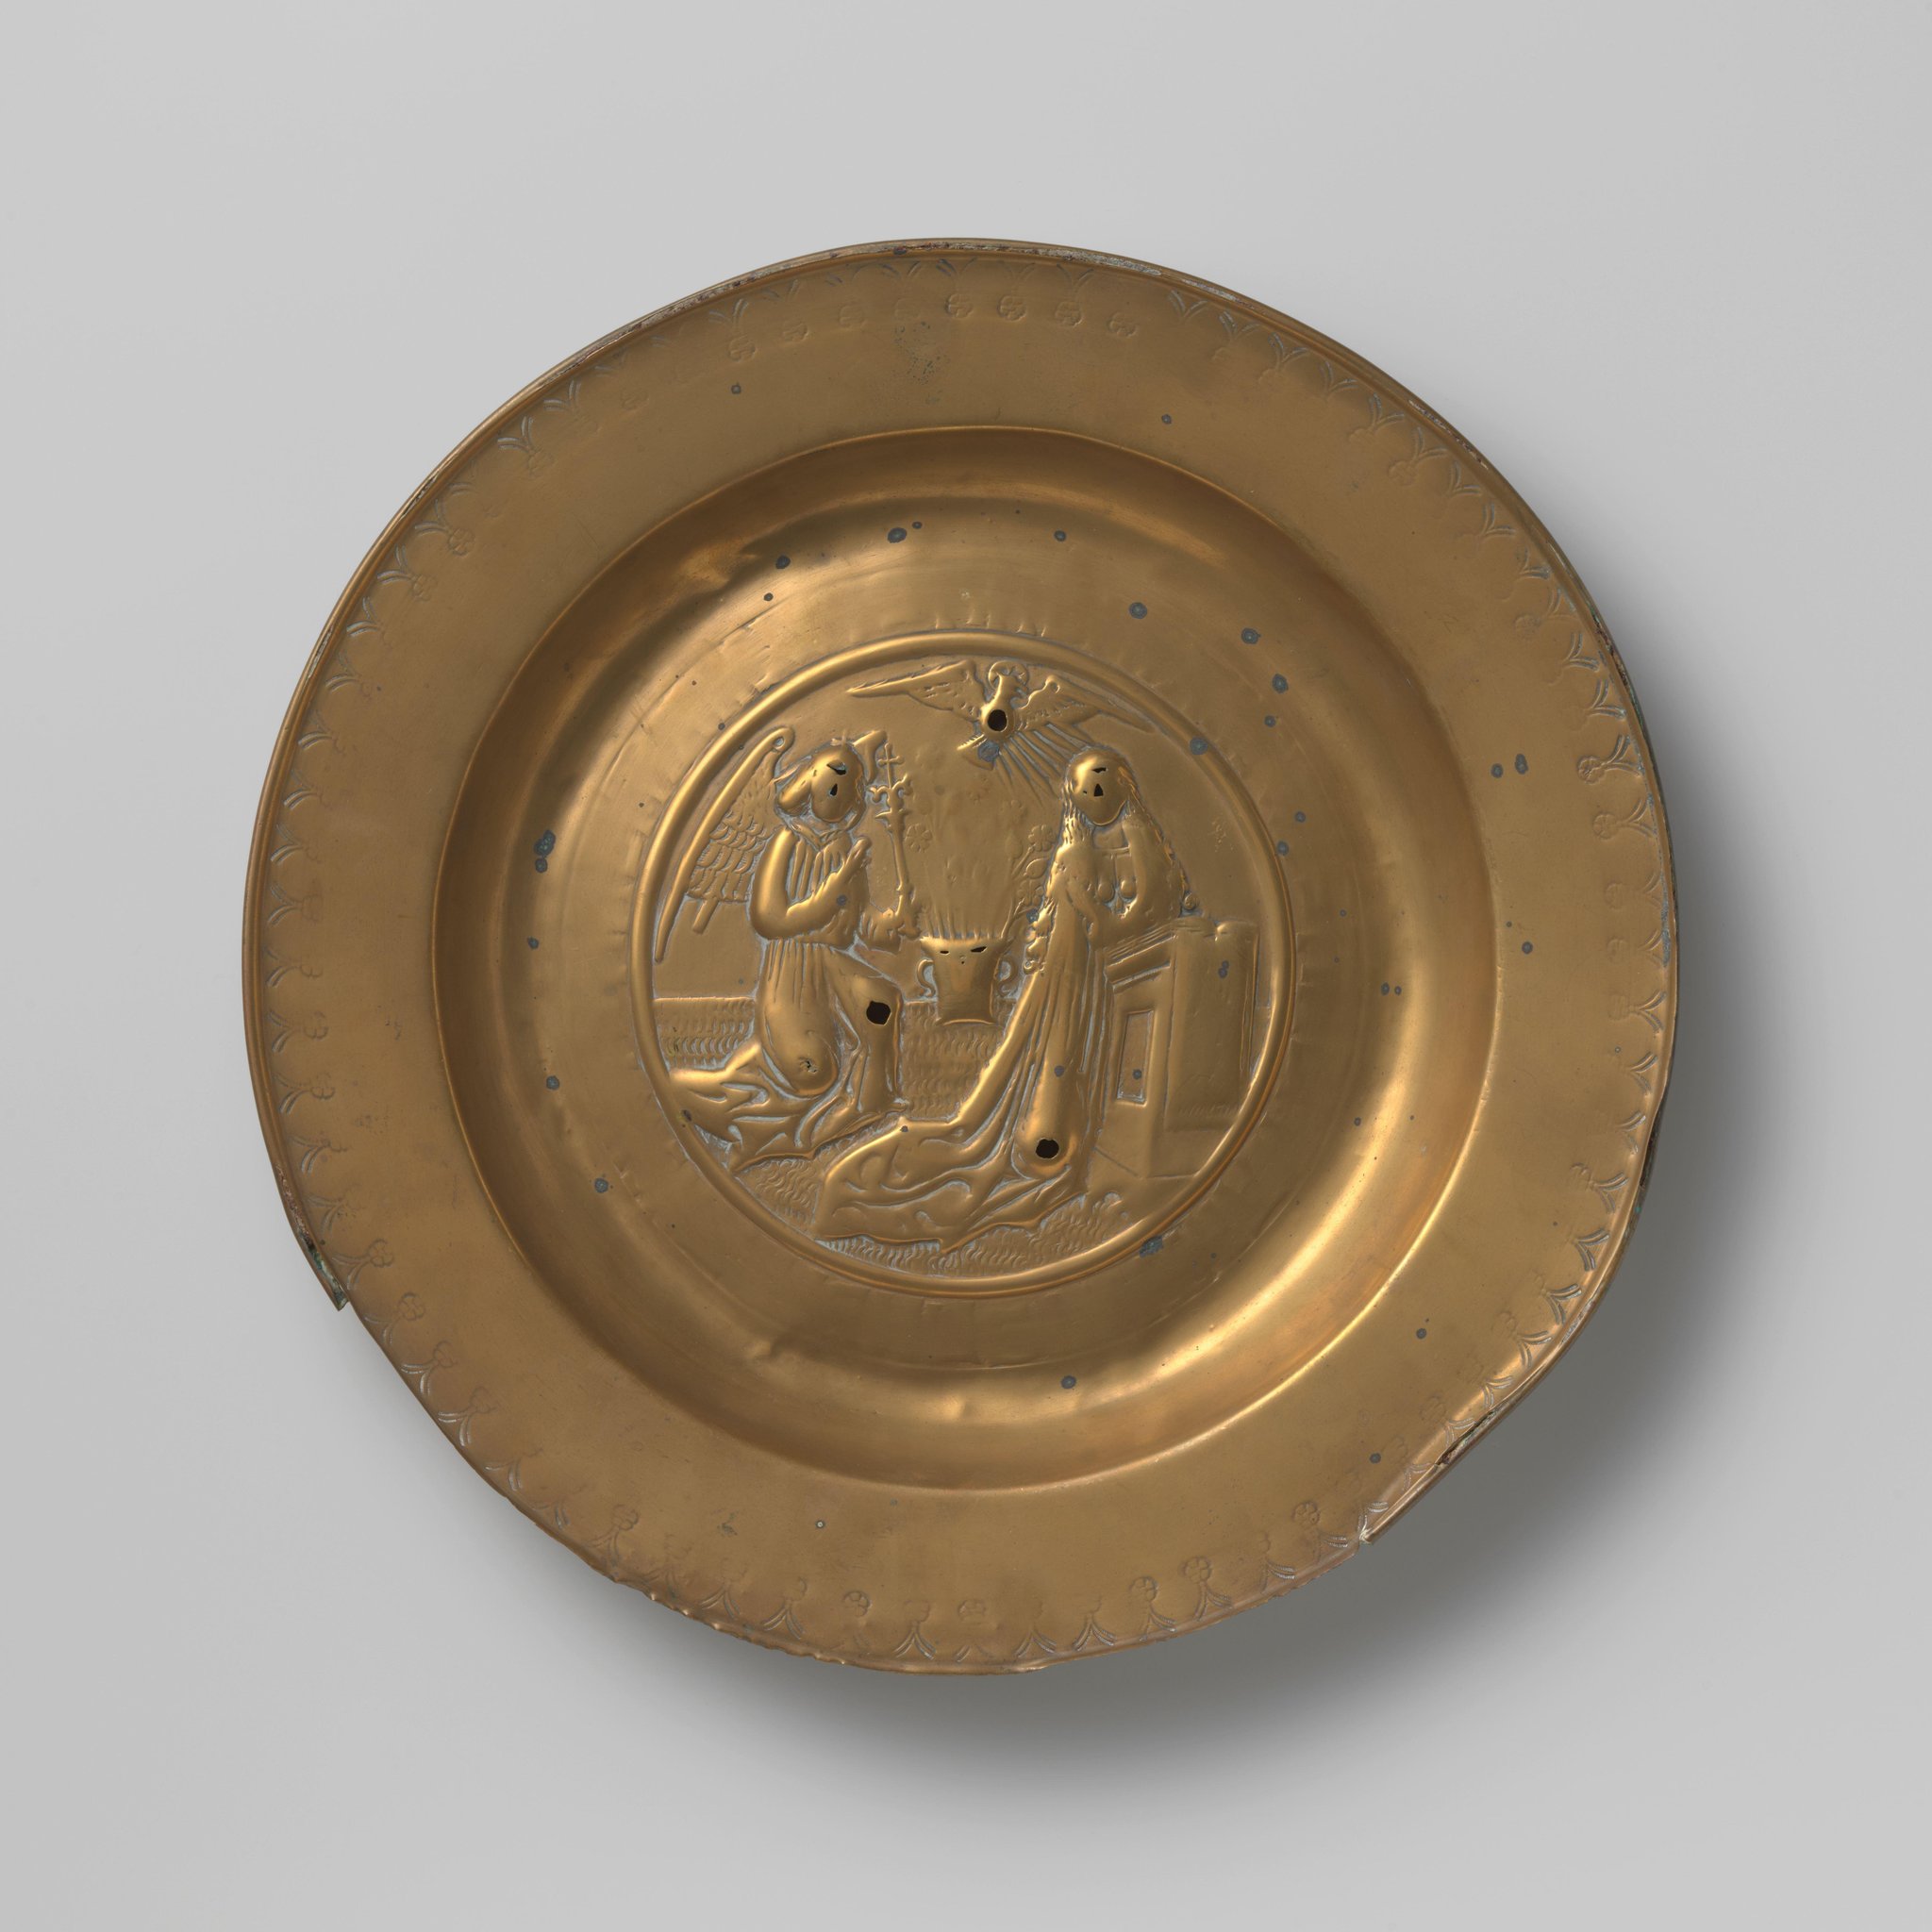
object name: platter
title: Schotel met Annunciatie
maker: Anonymous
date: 1500-1600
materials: brass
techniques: casting, punching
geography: nuremberg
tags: the annunciation: mary kneeling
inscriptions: inscription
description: In het plat van de schotel, die in het midden het centerpunt heeft, is met behulp van stempelvorm een voorstelling van de Verkondiging aan Maria geponst. Daaromheen is een ornamentaal letterfries (enige keren herhaald) aangebracht. Op de boord is tegen de met ijzerdraad verstevigde rand een ornament van kruisbloemen geponst.